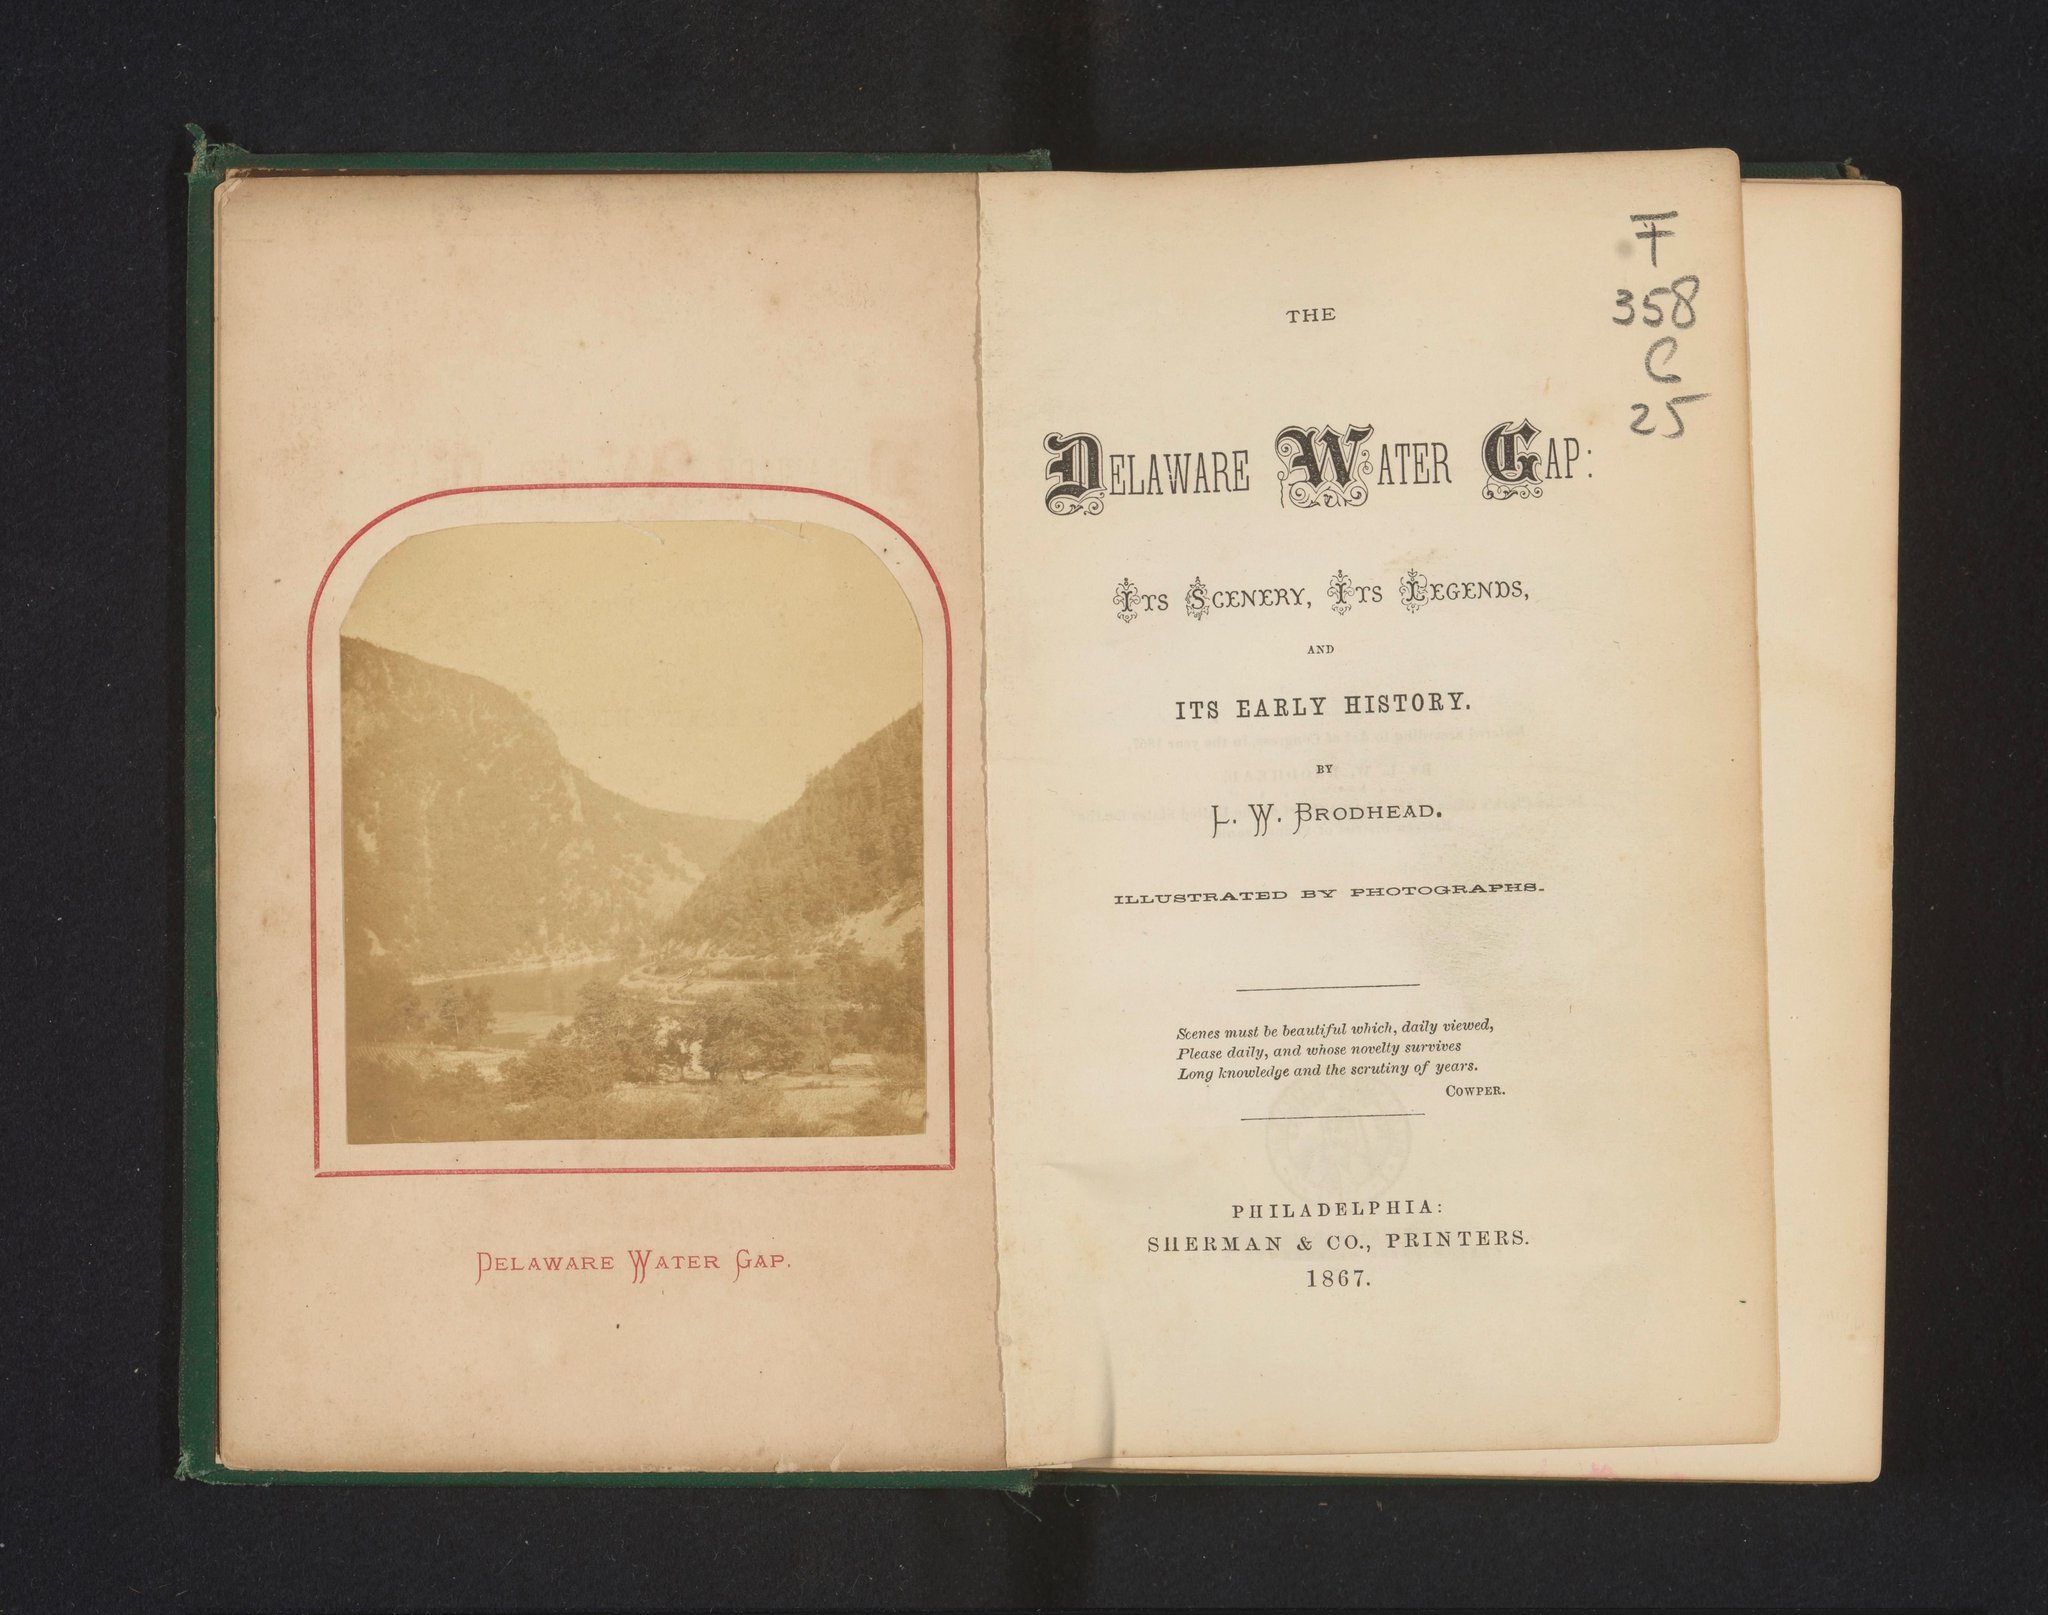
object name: book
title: The Delaware Water Gap : its scenery, its legends and its early history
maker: luke wills brodhead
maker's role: schrijver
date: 1867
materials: linen, paper, photographic support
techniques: albumen print, printing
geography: philadelphia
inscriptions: annotation: ‘590F/ $100,00/ 10 photos in text 1867/ Aunt Cora [...]/ Aunt Cora from Mary/ July 31st. 1867’, annotation: ‘ww’, date: ‘Mar 1997’